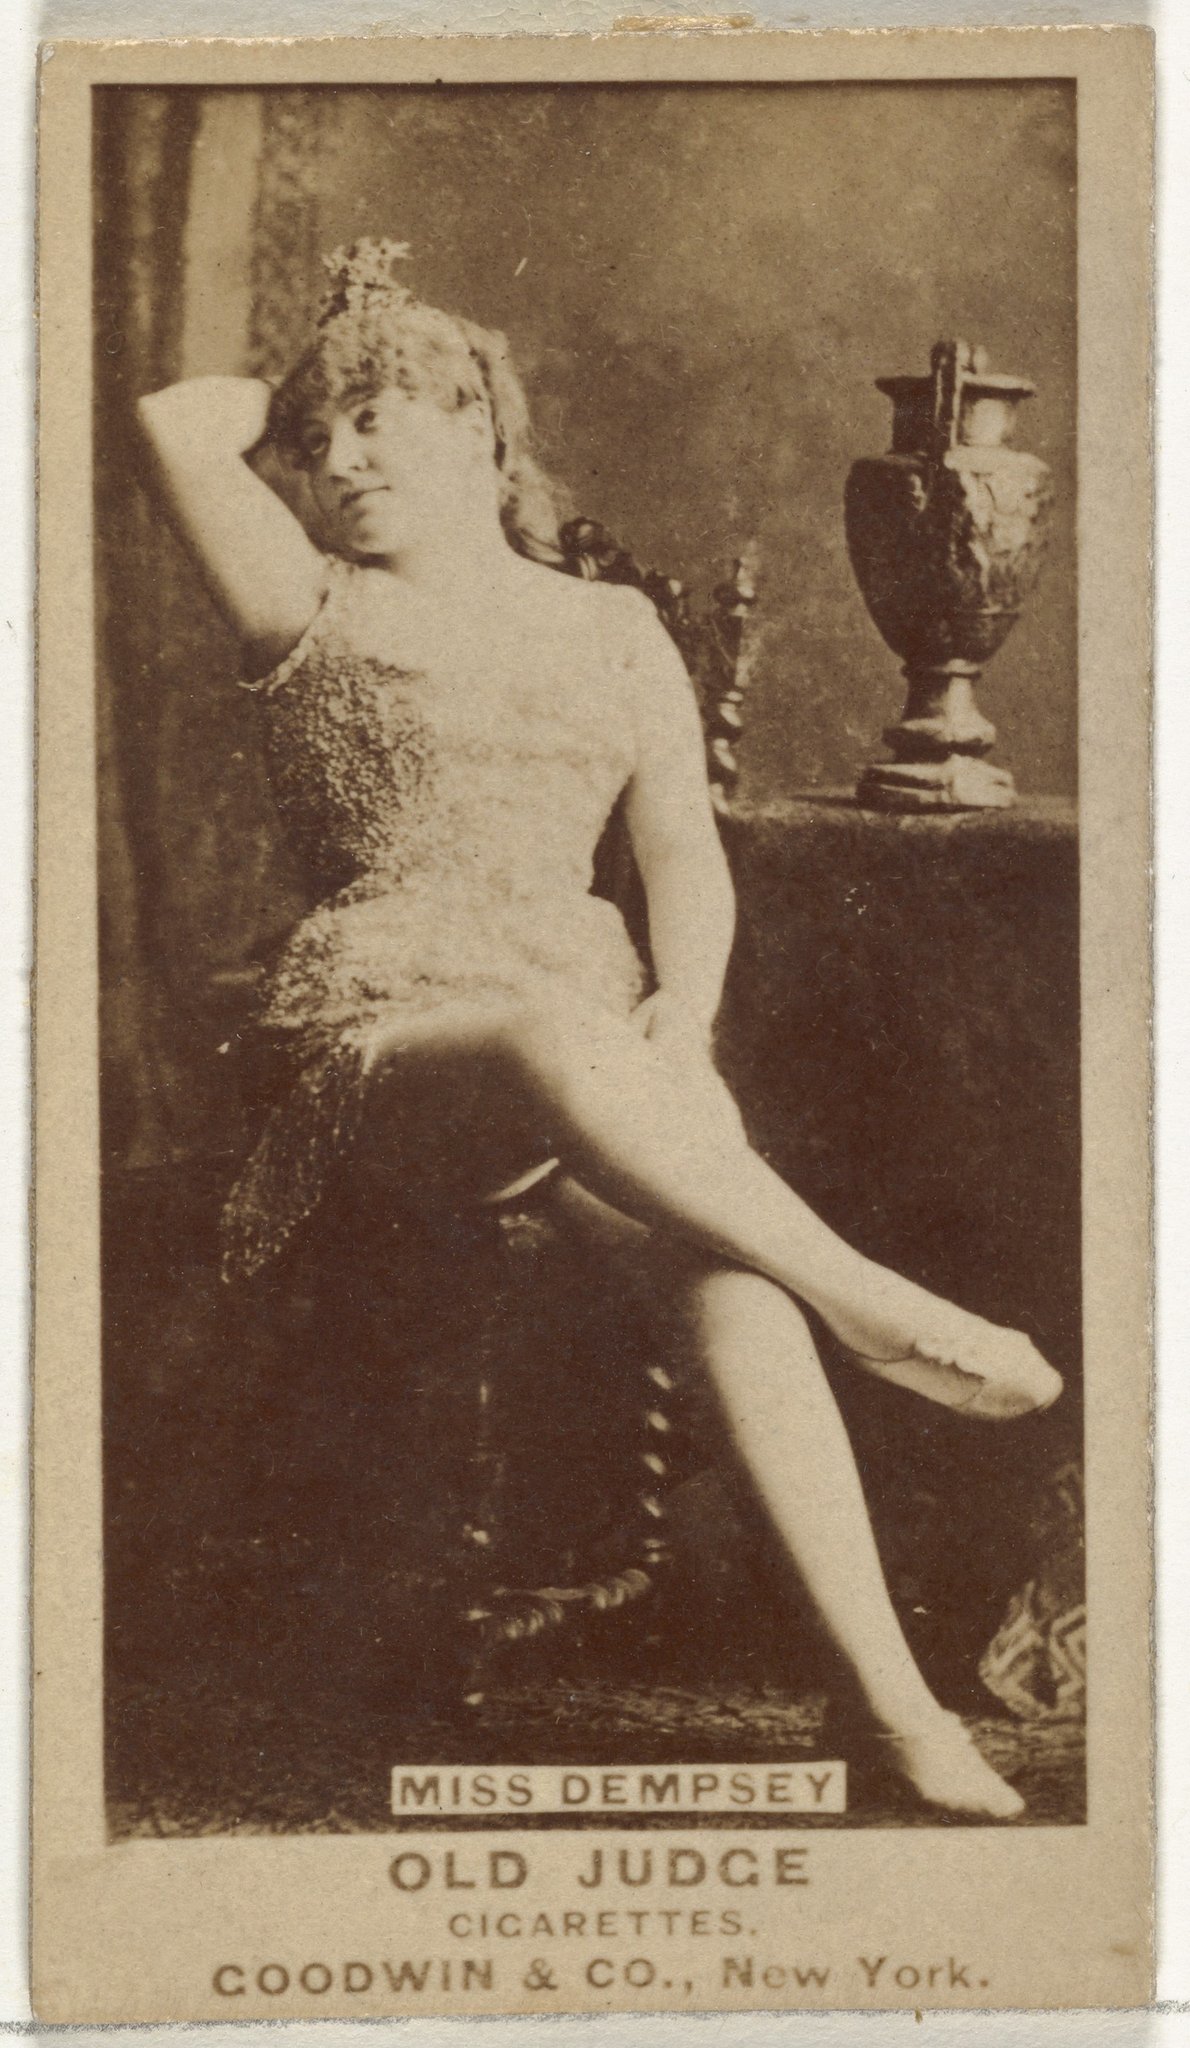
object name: photograph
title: Miss Dempsey, from the Actors and Actresses series (N171) for Old Judge Cigarettes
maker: goodwin & company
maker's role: publisher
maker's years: 1850-1950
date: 1886-1890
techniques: albumen silver print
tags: portraits,women,actresses